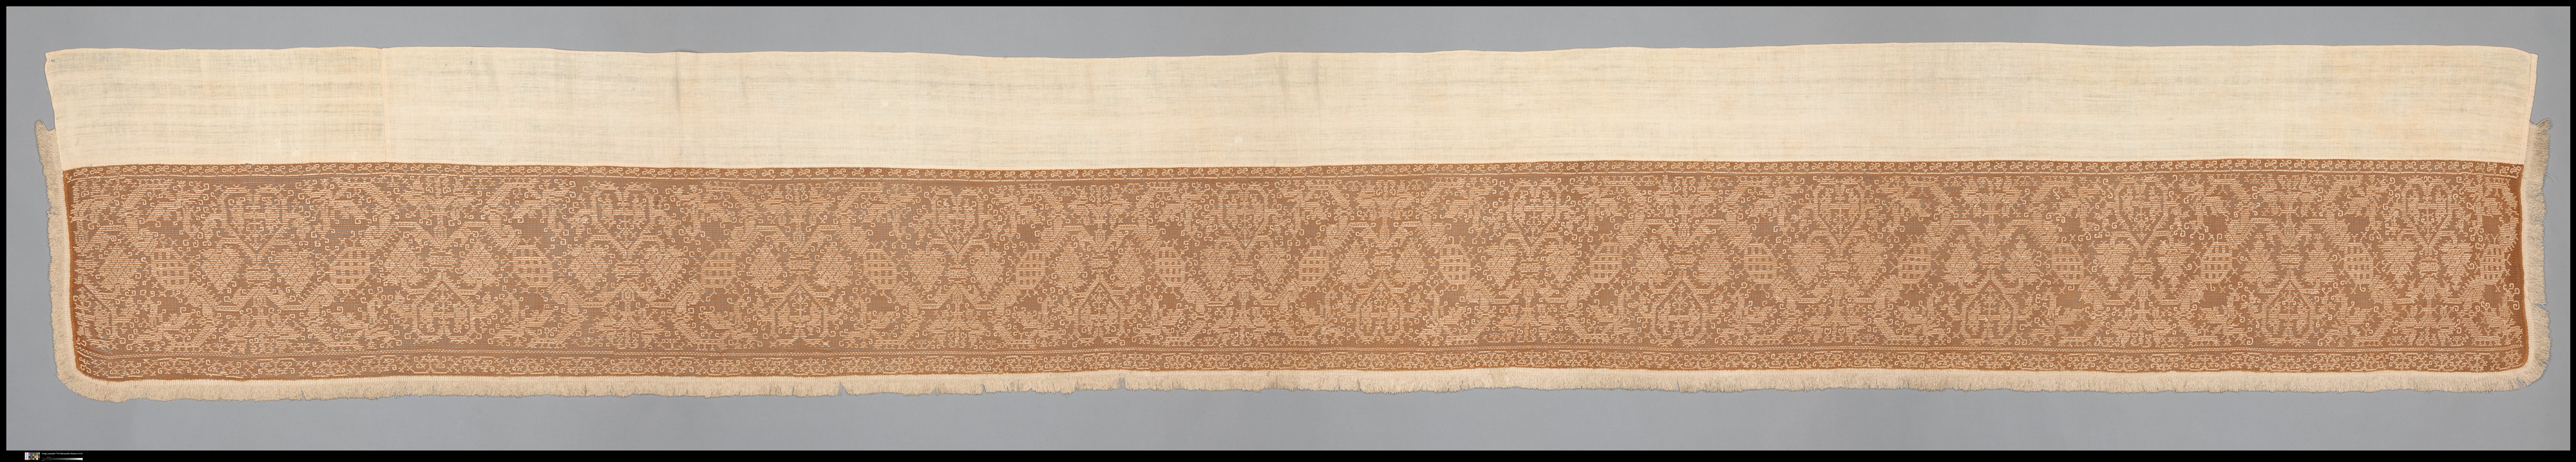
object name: valance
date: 1601-1700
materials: linen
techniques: embroidery